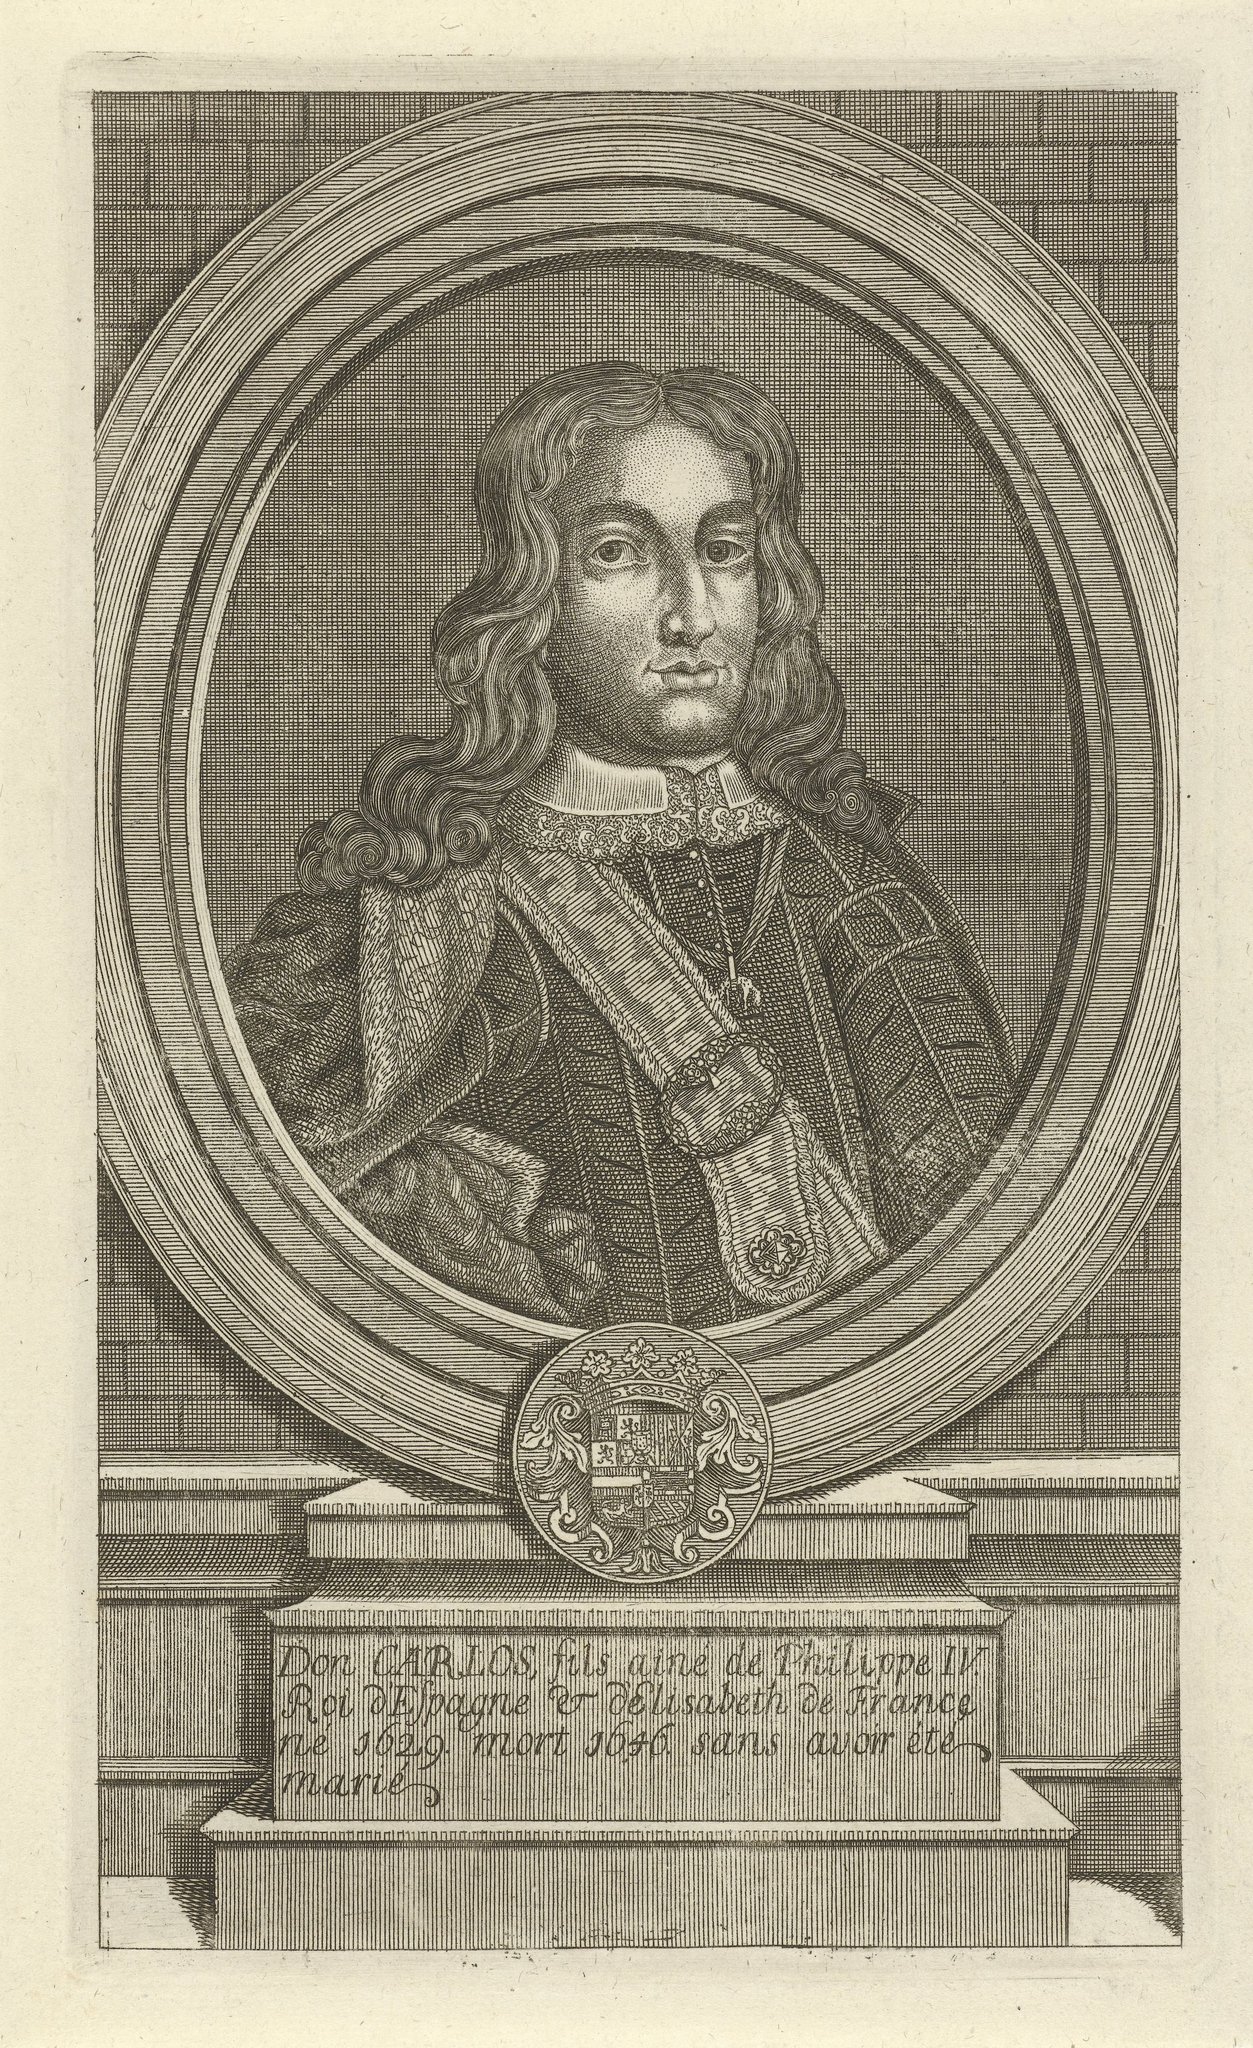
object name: print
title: Portret van prins Don Carlos van Spanje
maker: jan lauwryn krafft (i)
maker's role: print maker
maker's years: 1694-1785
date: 1704-1765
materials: paper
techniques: engraving, etching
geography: southern netherlands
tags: historical persons, knighthood order of the golden fleece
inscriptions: collector's mark: Lugt 2228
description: Portret van prins Don Carlos van Spanje, de eerste zoon van Filips II van Spanje. Hij draagt een mantel en een ketting met het teken van de Orde het Gulden Vlies. Op de plint zijn naam en titels.